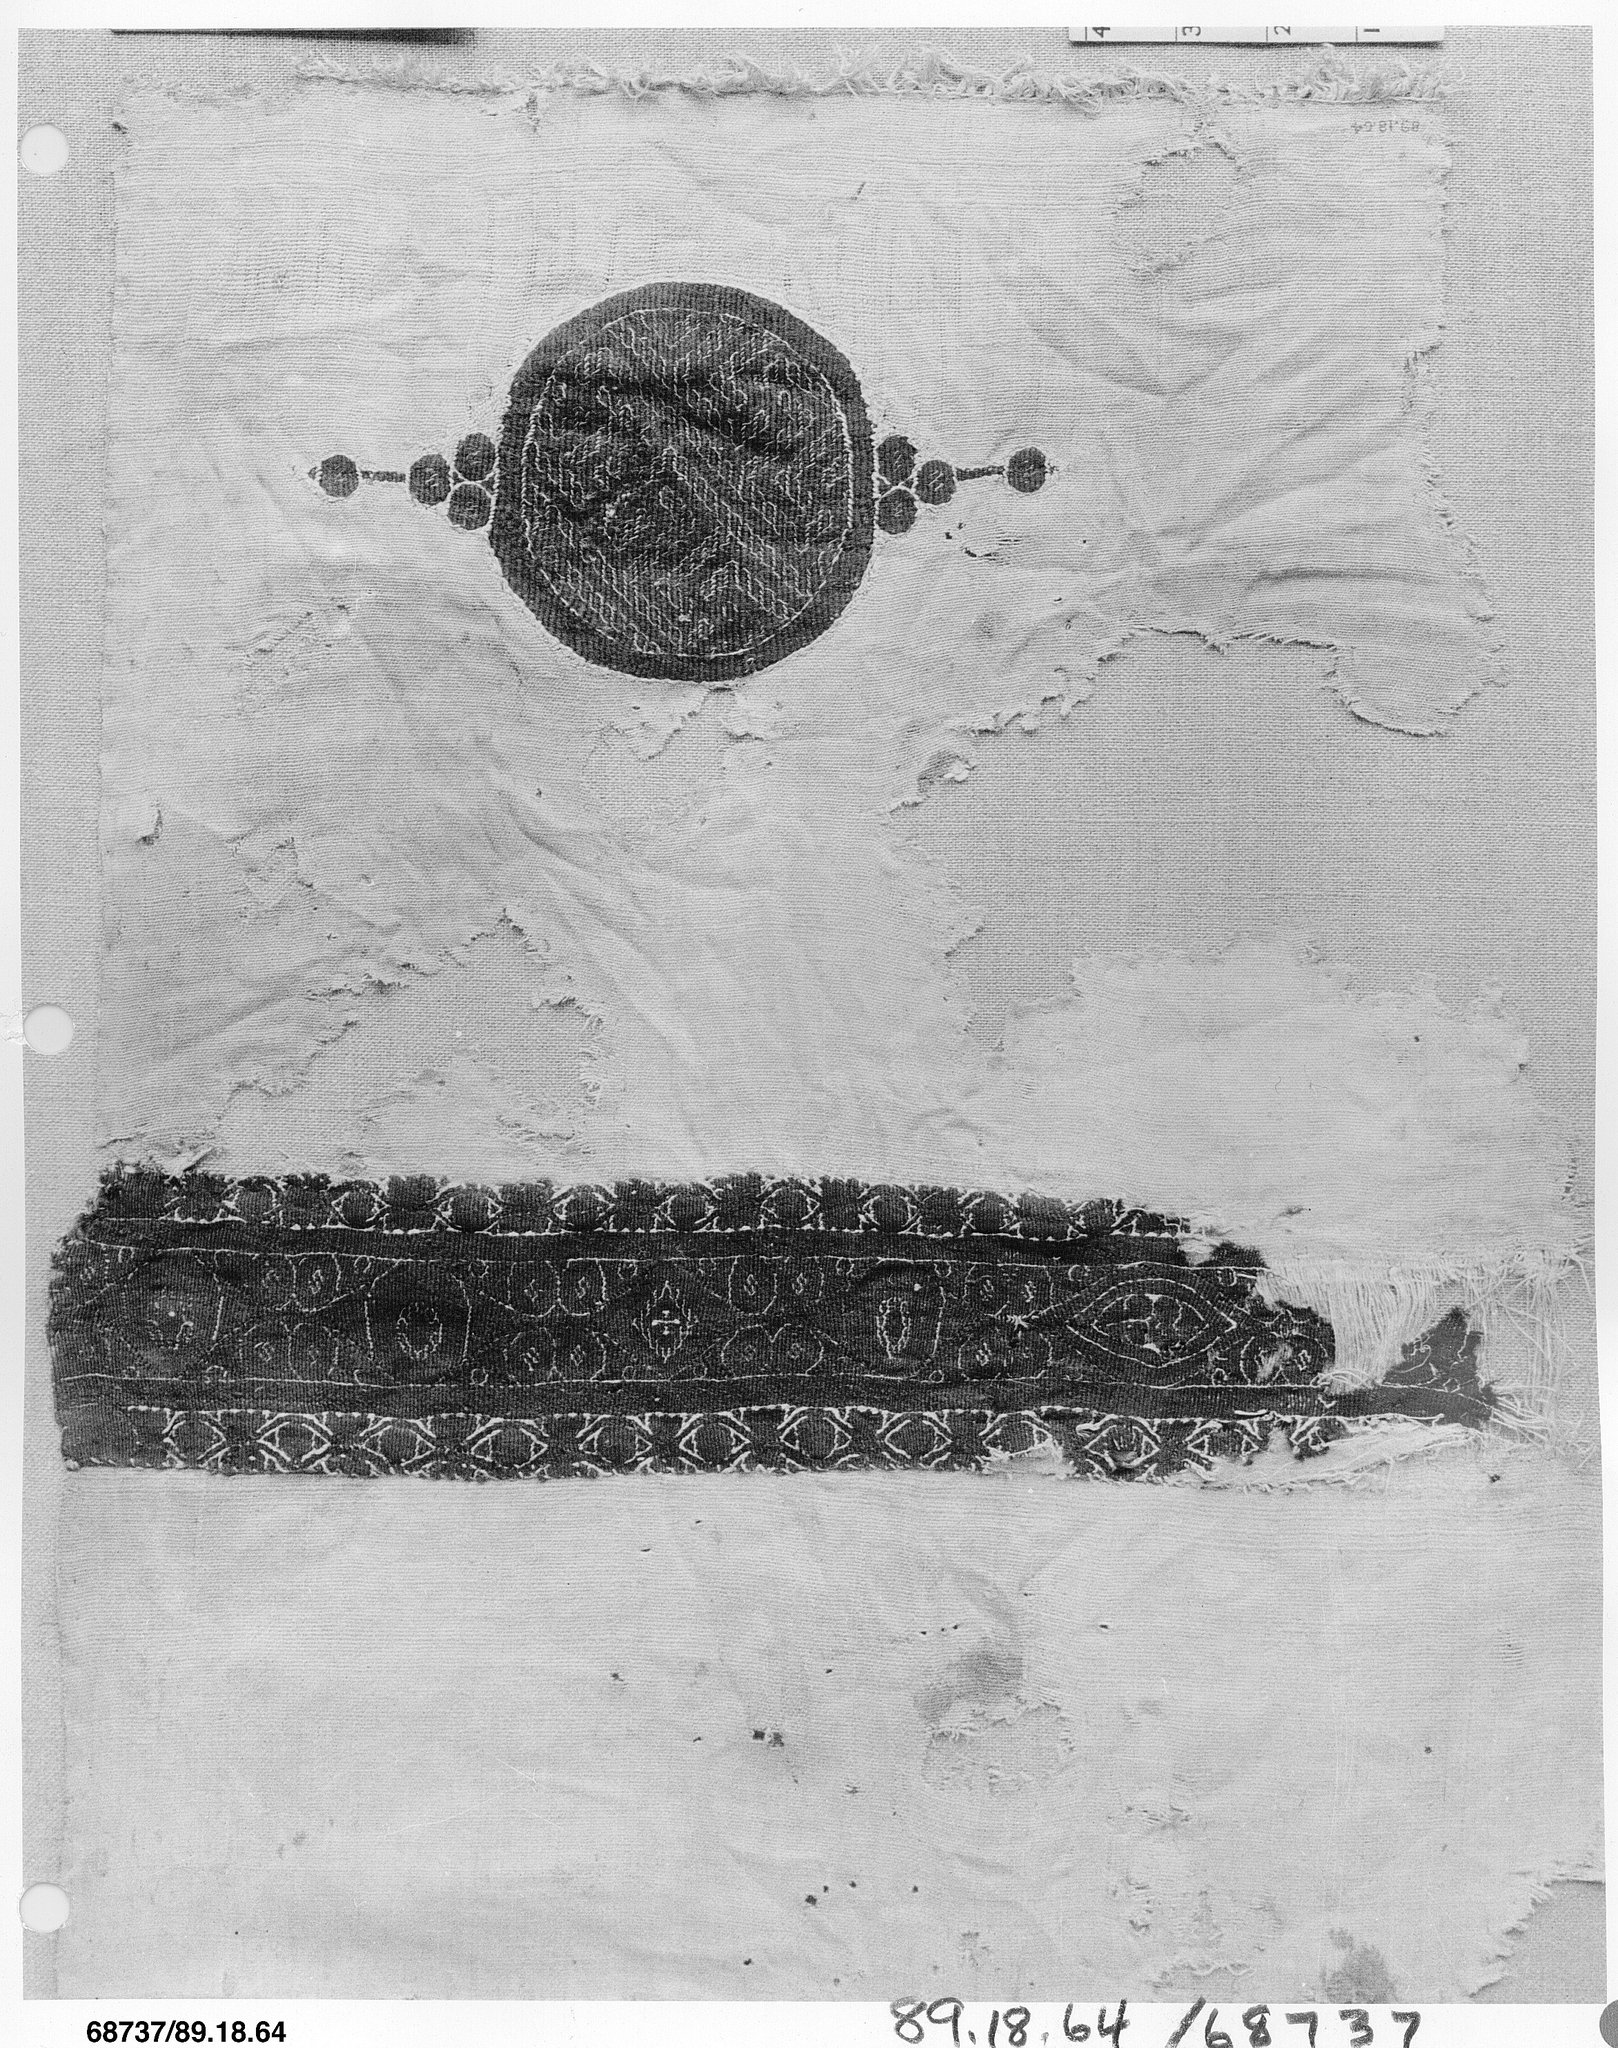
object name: textile fragment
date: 201-400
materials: linen, wool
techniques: weave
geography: egypt